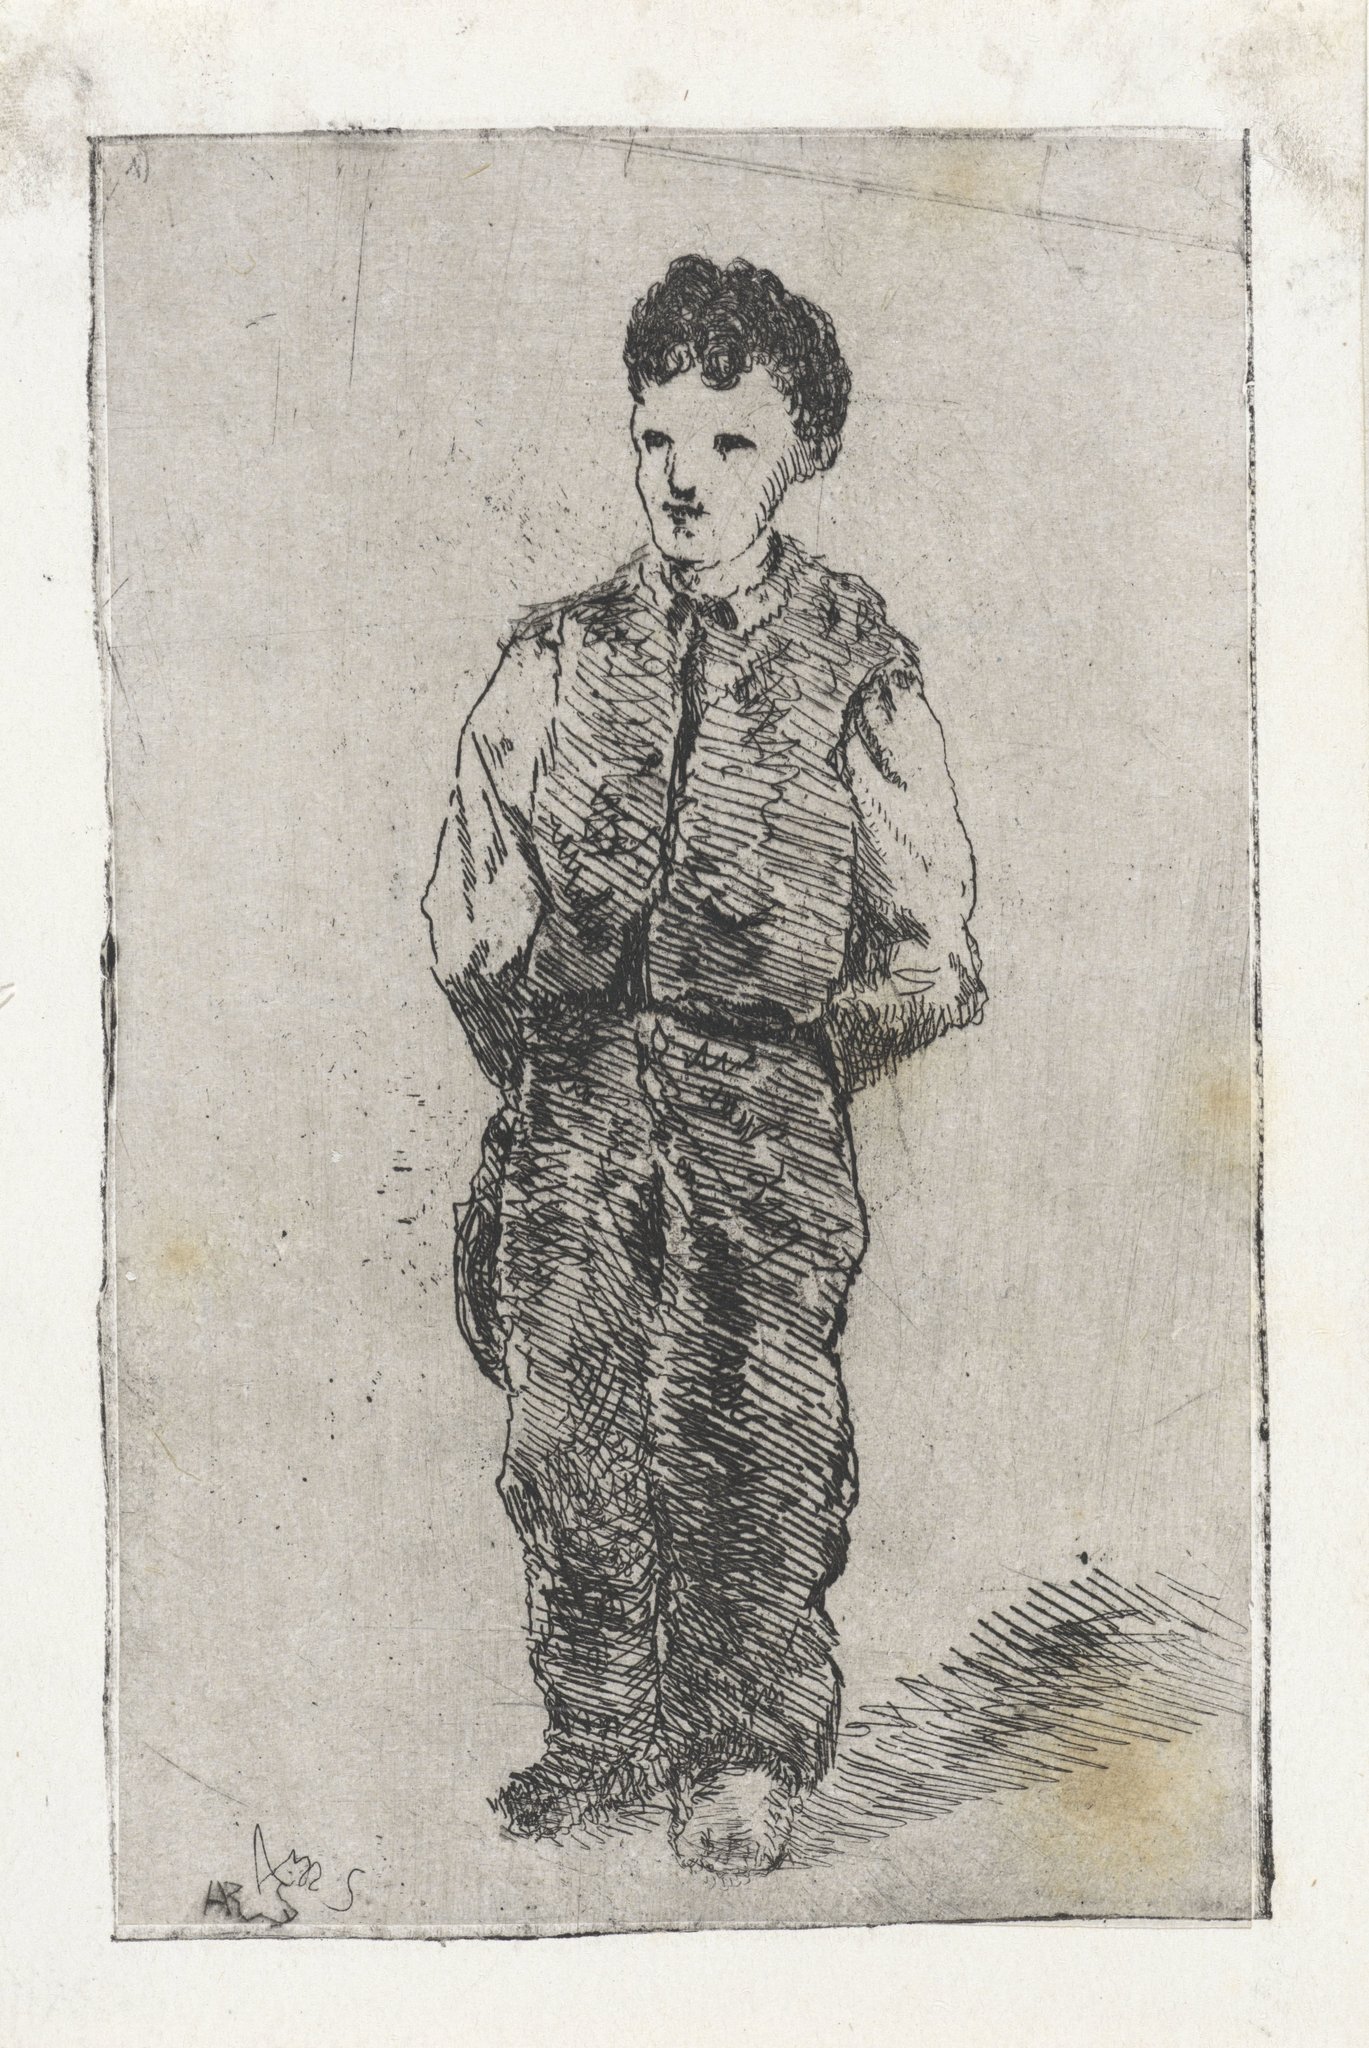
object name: print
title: Jonge man in een overall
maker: arnoud schaepkens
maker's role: print maker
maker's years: 1816-1904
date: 1831-1904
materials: paper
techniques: drypoint, etching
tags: youth, adolescent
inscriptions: collector's mark: Lugt 2228